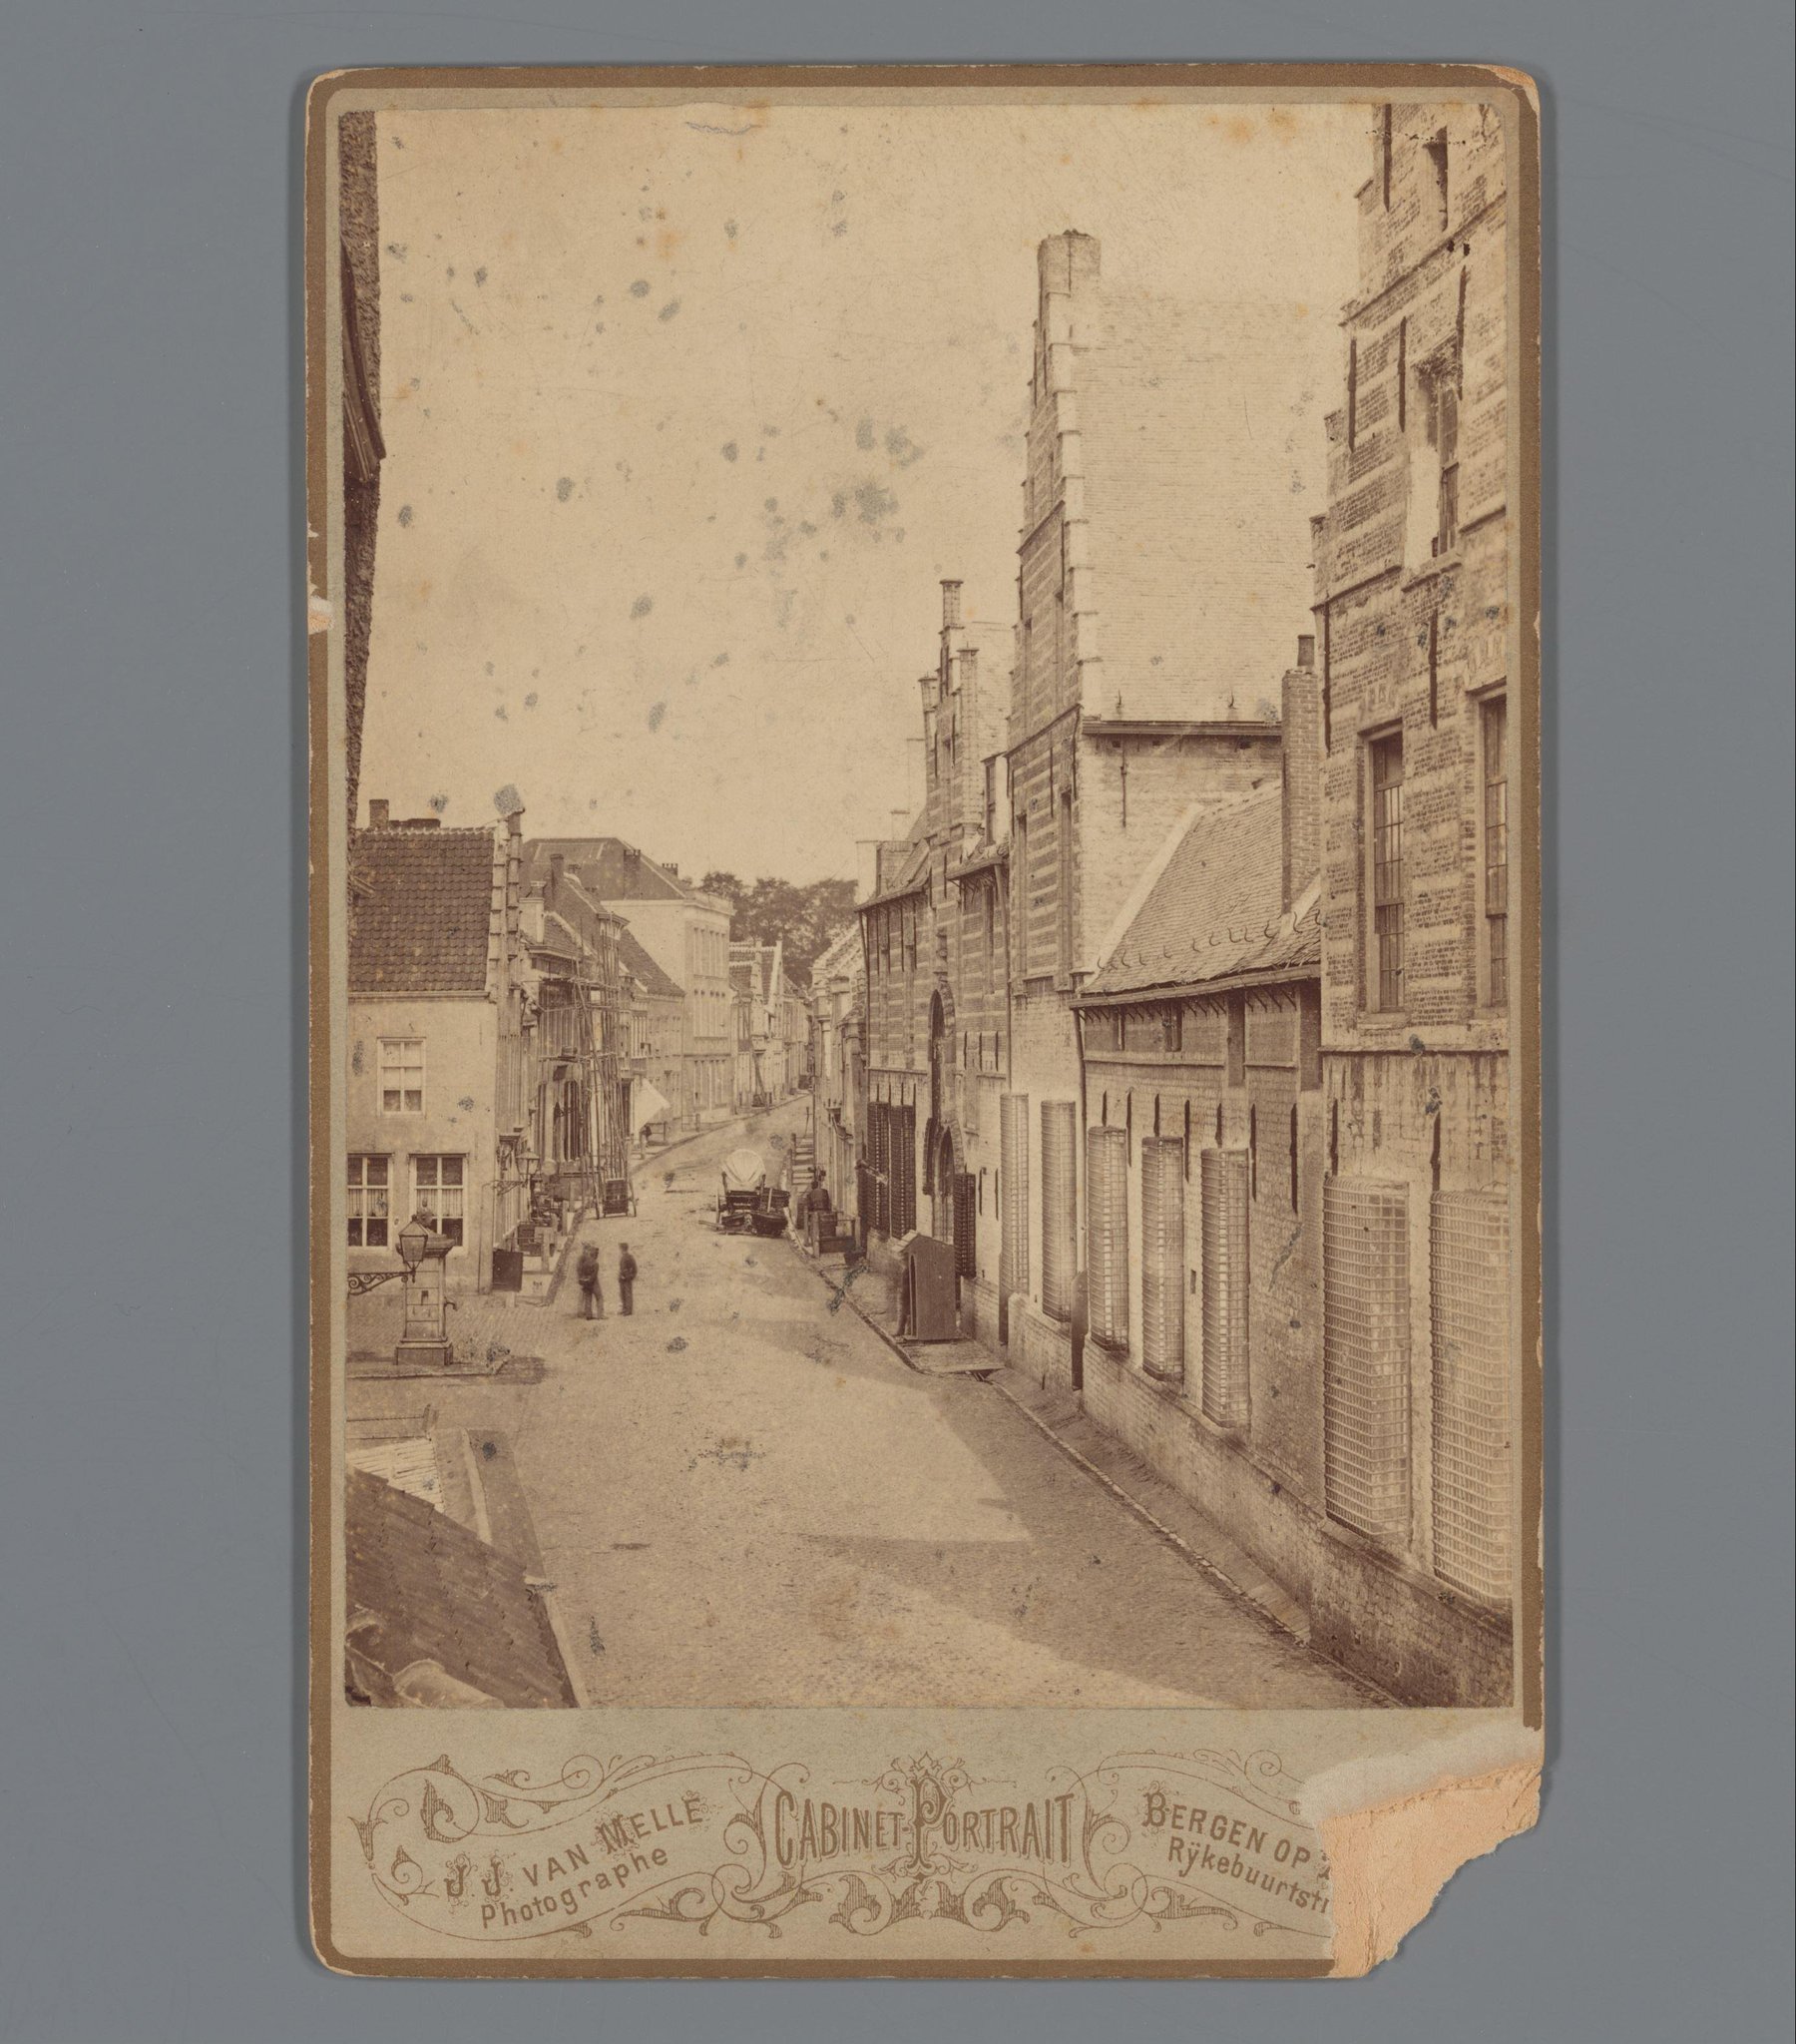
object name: photograph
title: Gezicht op het Markiezenhof te Bergen op Zoom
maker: jannis jacobus van melle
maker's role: fotograaf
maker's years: 1829-1911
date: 1892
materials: cardboard, photographic support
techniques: albumen print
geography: bergen op zoom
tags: street (+ city(-scape) with figures, staffage)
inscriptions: annotation: ‘Markiezen-hof/ Bergen op Zoom/ 2 Nov. '92 foto J.J. van Melle’, inscription: ‘J.J. van Melle/ Photographe/ Cabinet-Portrait/ Bergen op Zoom/ Rykebuurtstraat’